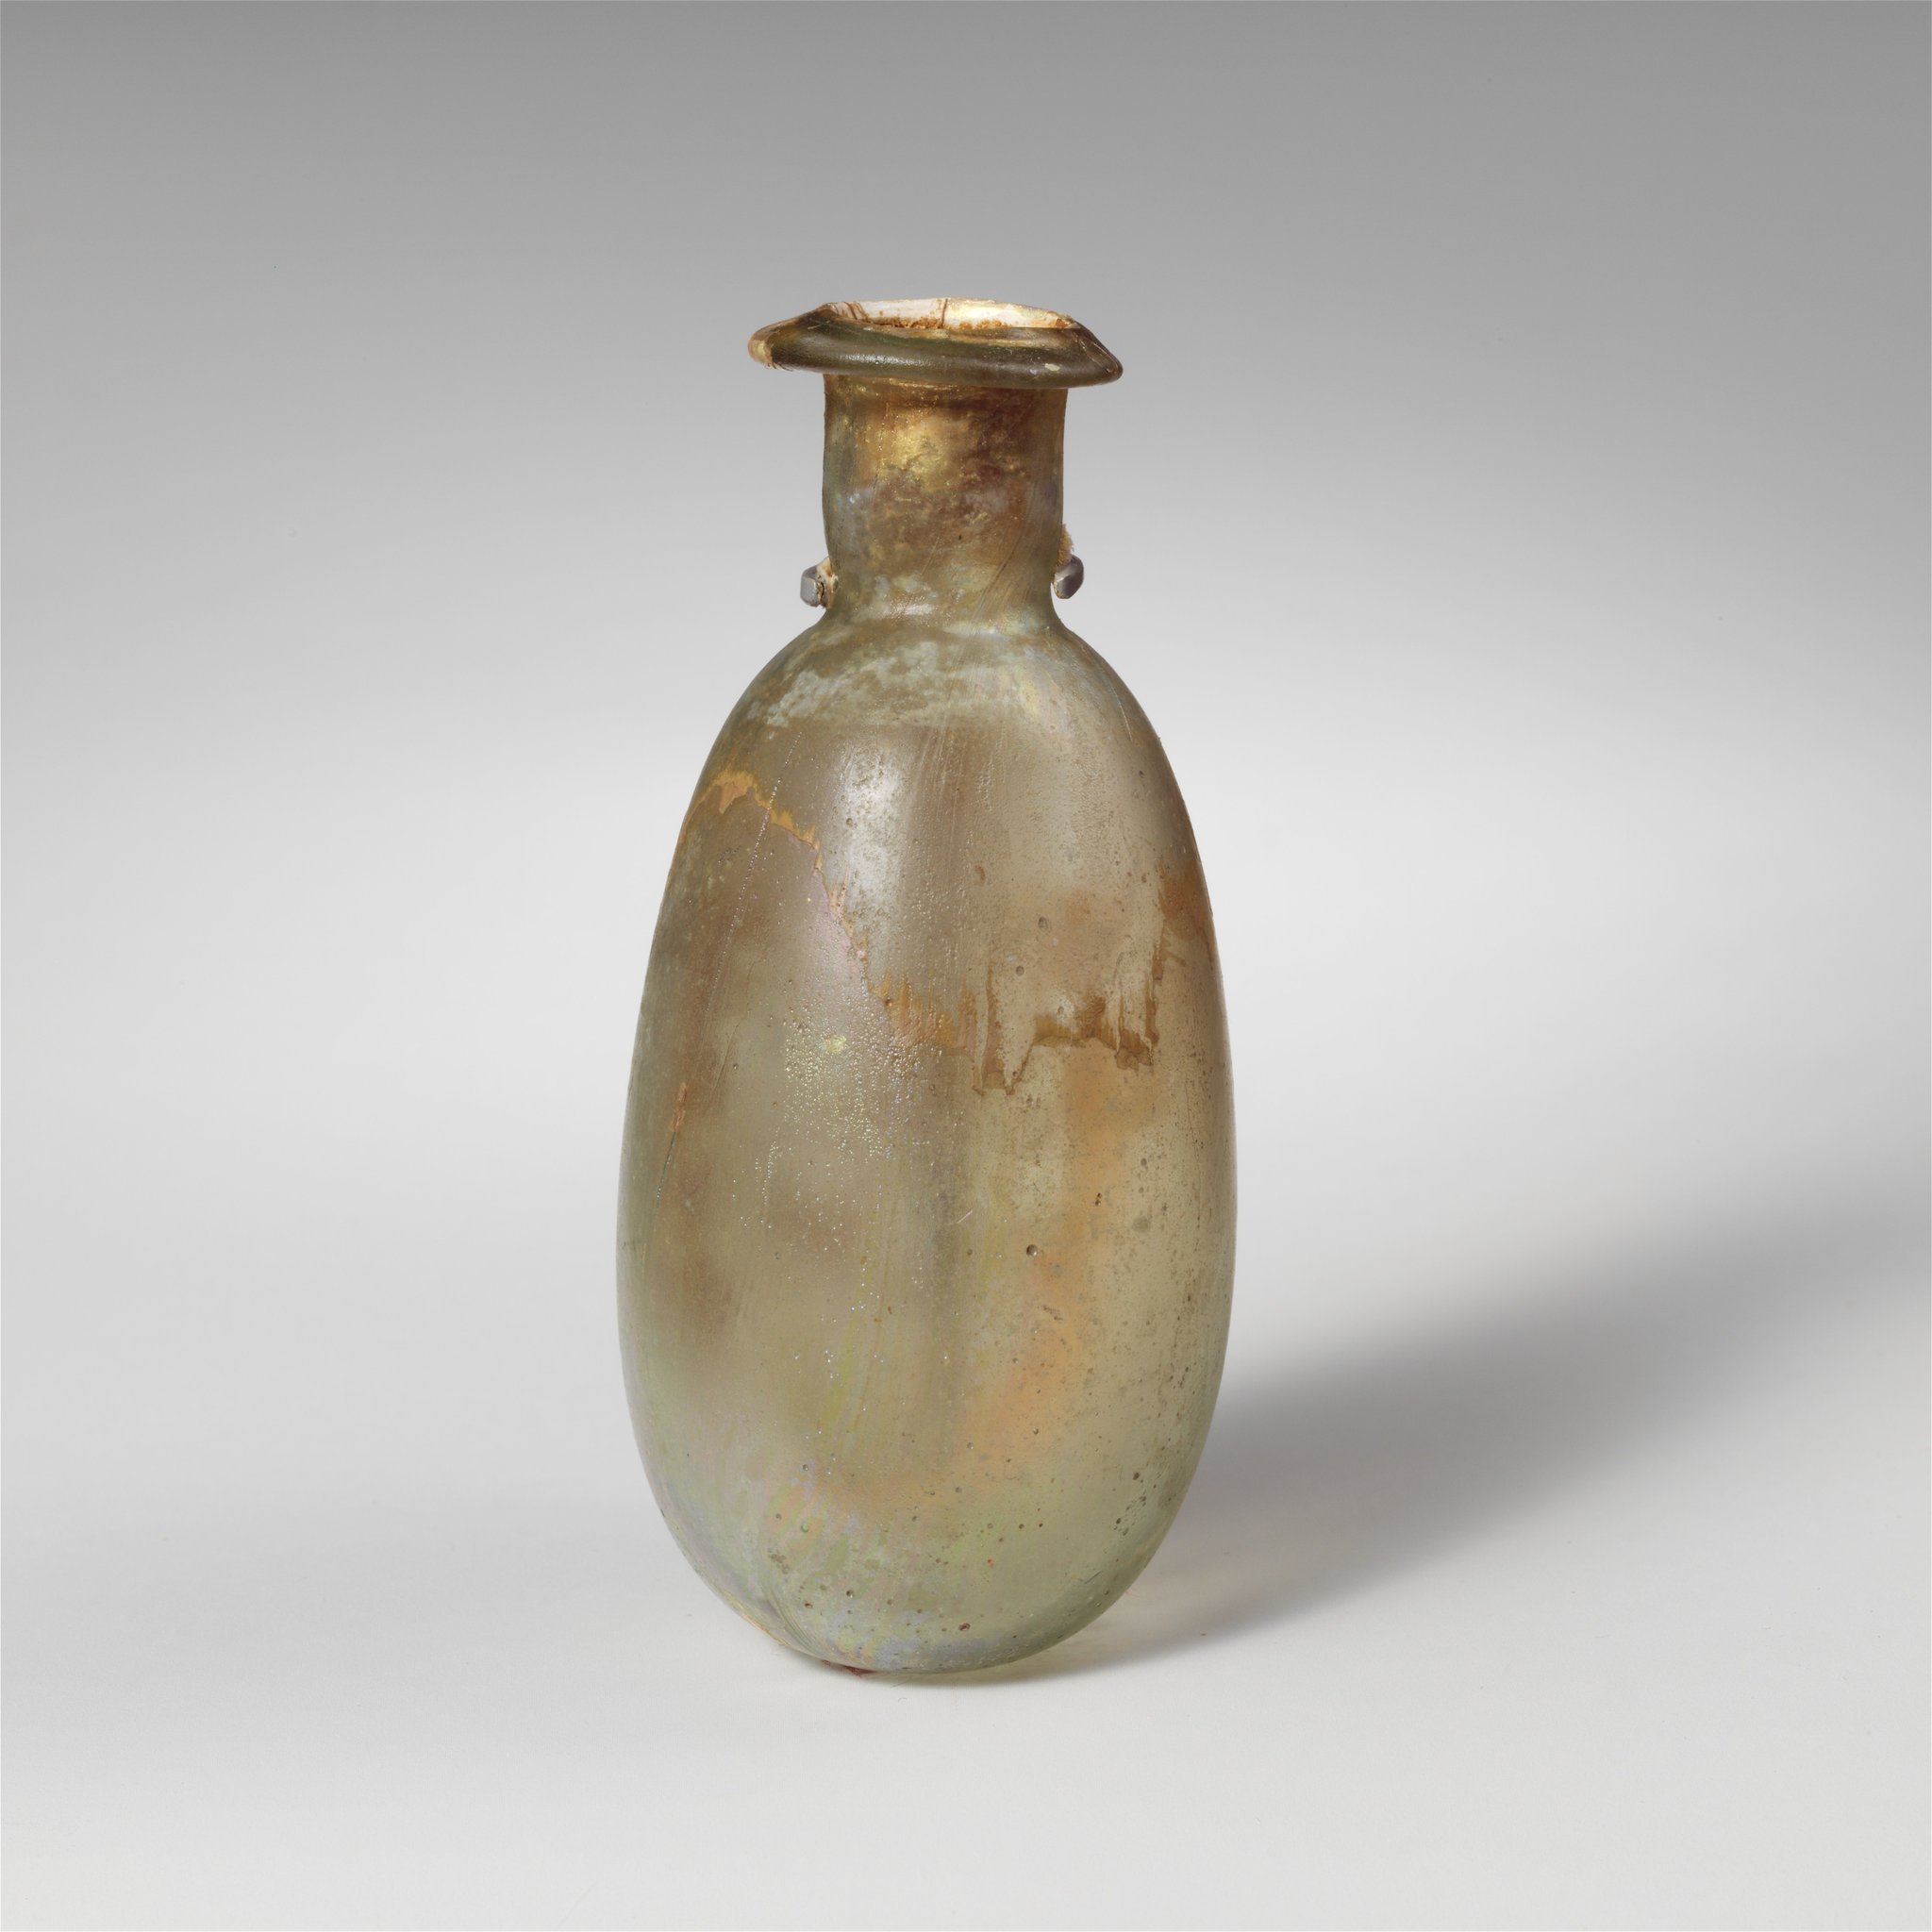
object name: perfume bottle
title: Glass perfume bottle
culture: roman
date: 1-200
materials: glass